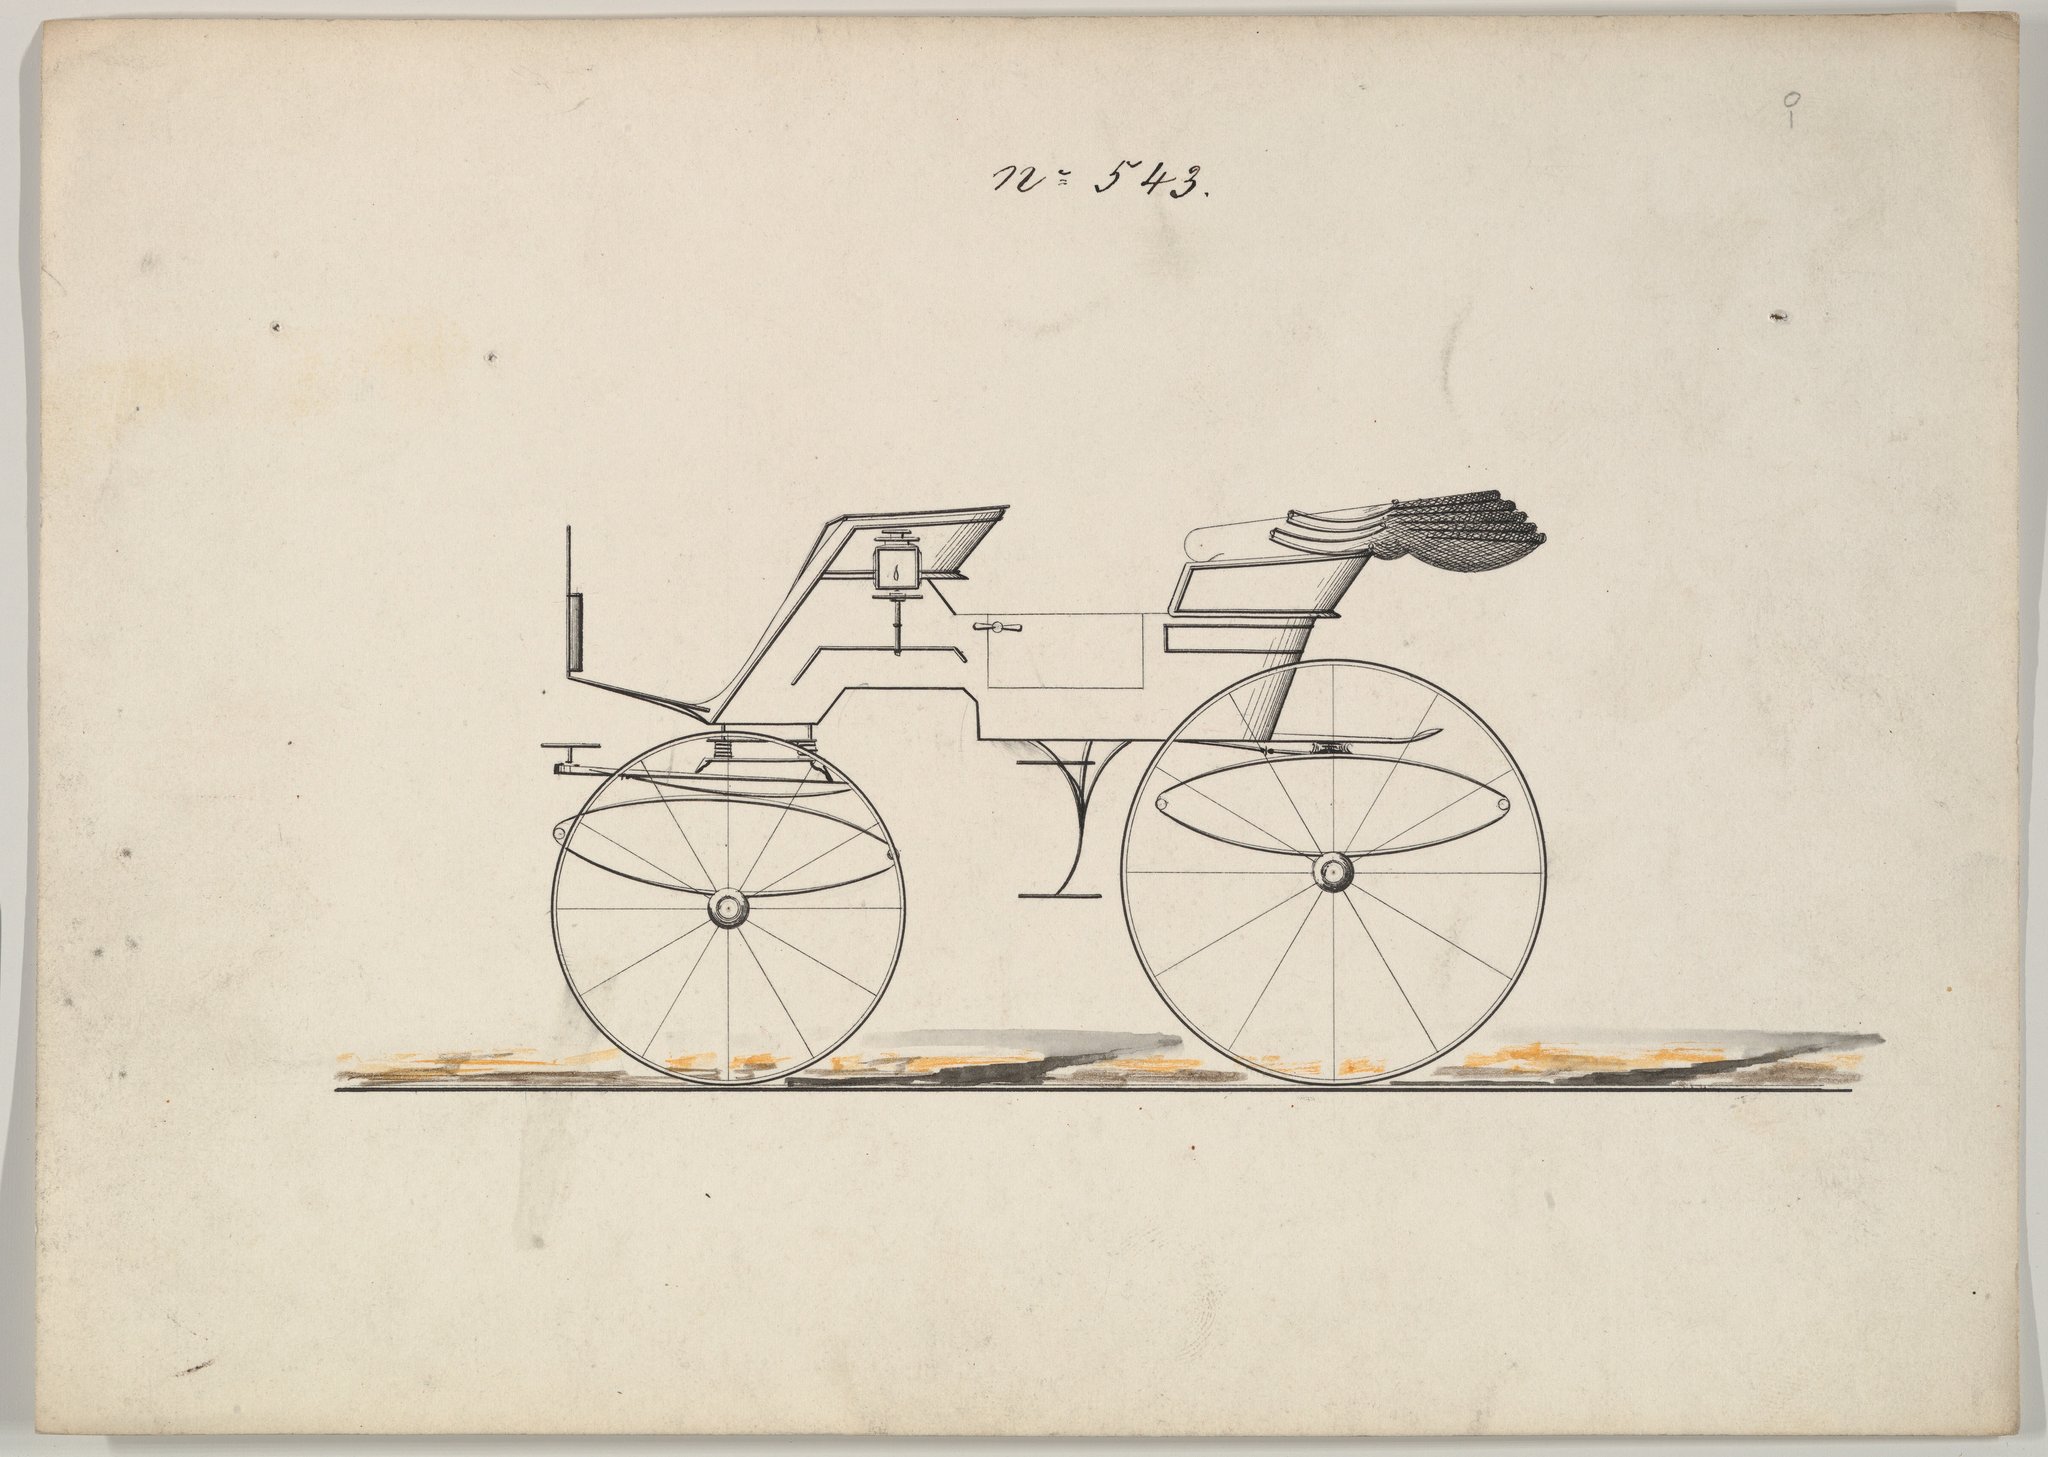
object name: drawing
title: Design for Phaeton, no. 543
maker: brewster & co.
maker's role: manufacturer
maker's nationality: american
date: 1850-1874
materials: gouache, ink, watercolor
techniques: pen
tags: carriages